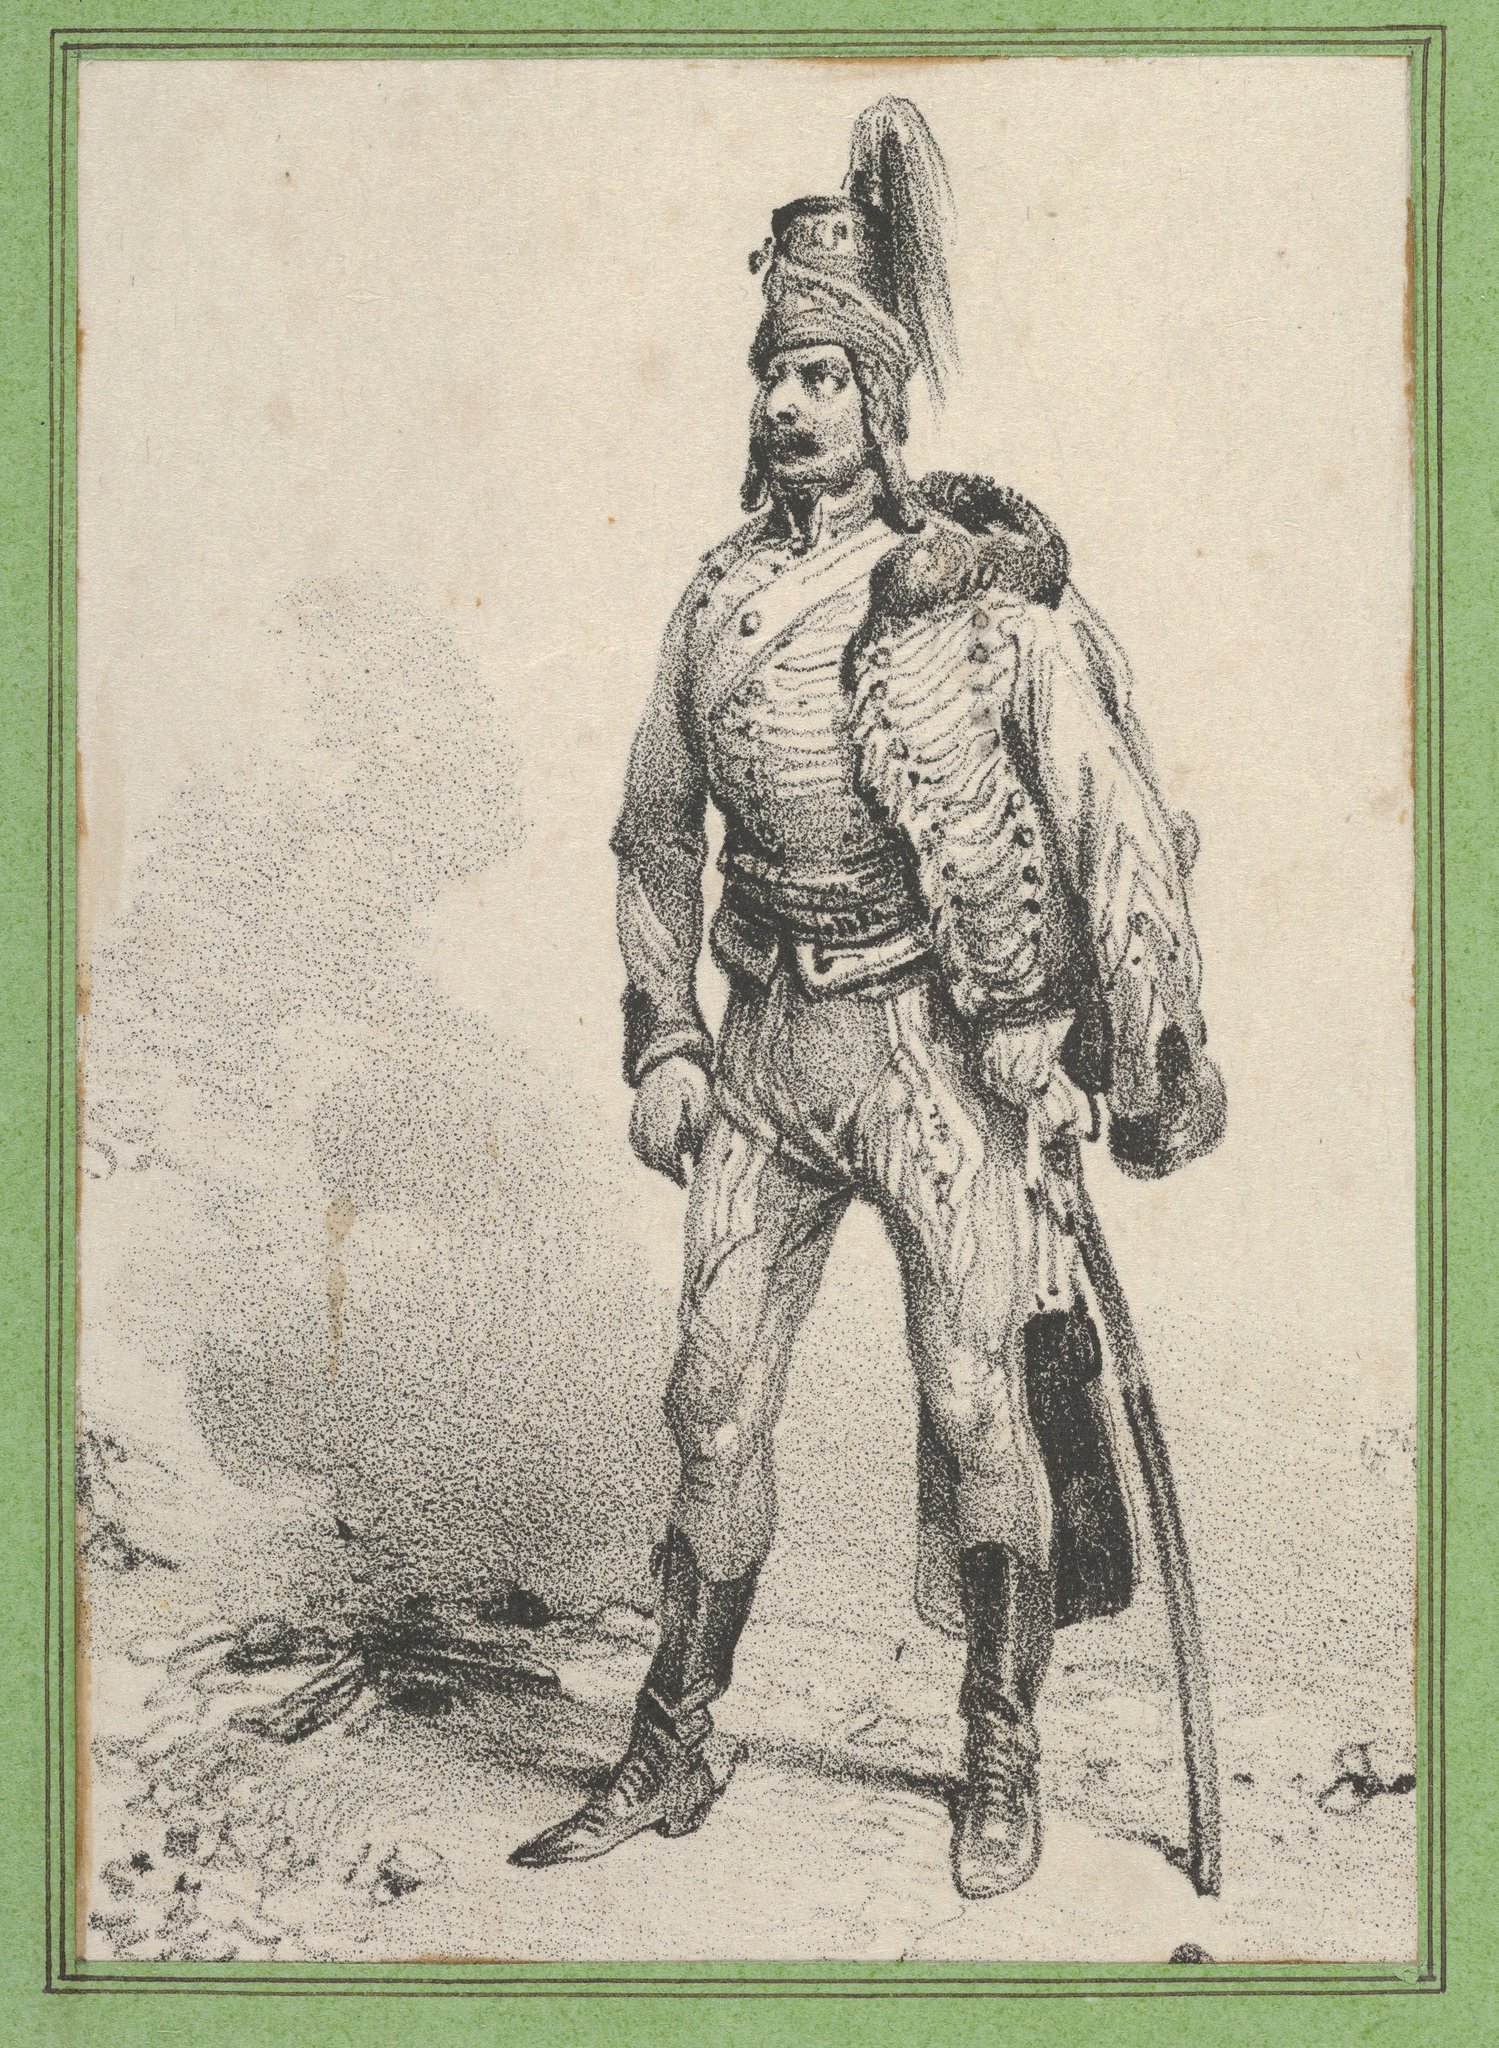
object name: print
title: Standing soldier with his jacket on one shoulder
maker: victor adam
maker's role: artist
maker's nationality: french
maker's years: 1801-1866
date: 1834-1866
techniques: lithograph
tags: soldiers,men,portraits